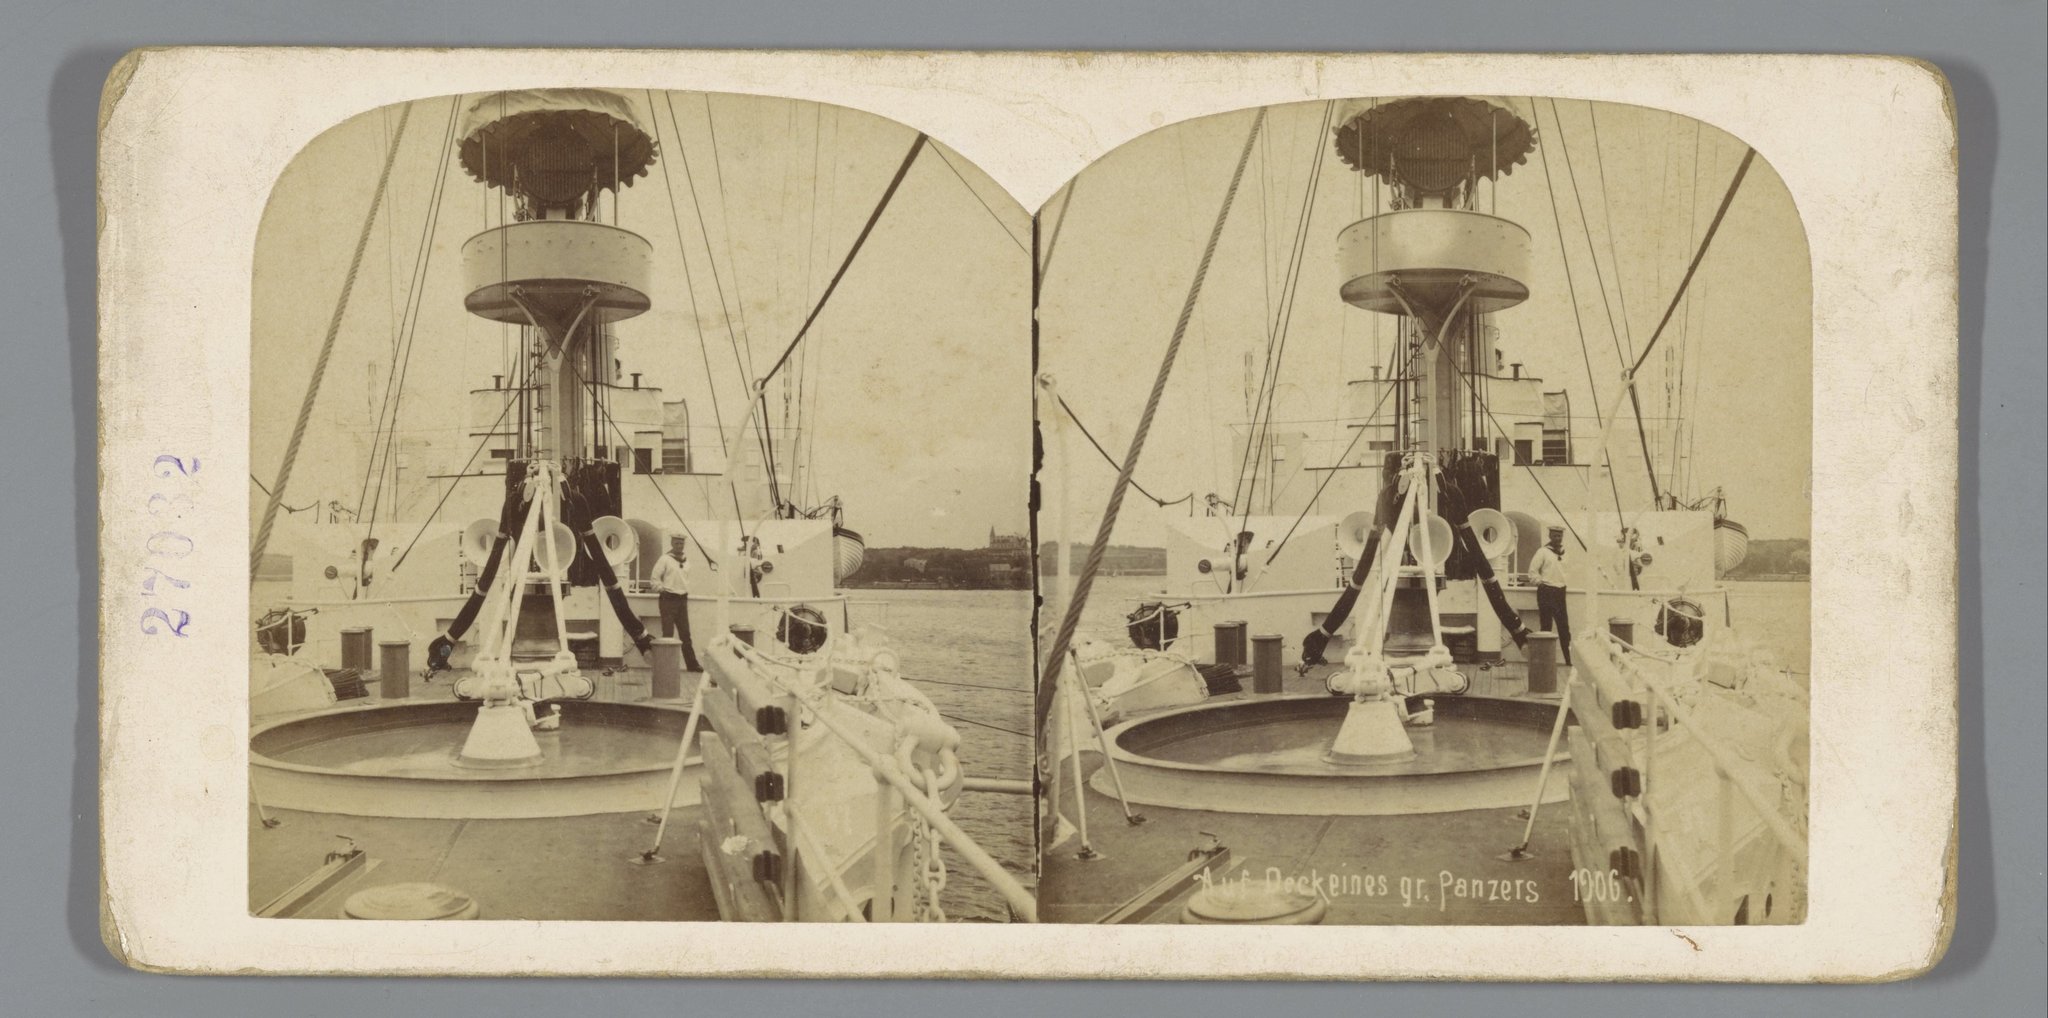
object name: stereograph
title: Auf Deck eines gr. Panzers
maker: Anonymous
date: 1906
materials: cardboard, paper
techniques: albumen print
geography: germany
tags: crew ~ ship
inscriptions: number: ‘27032’